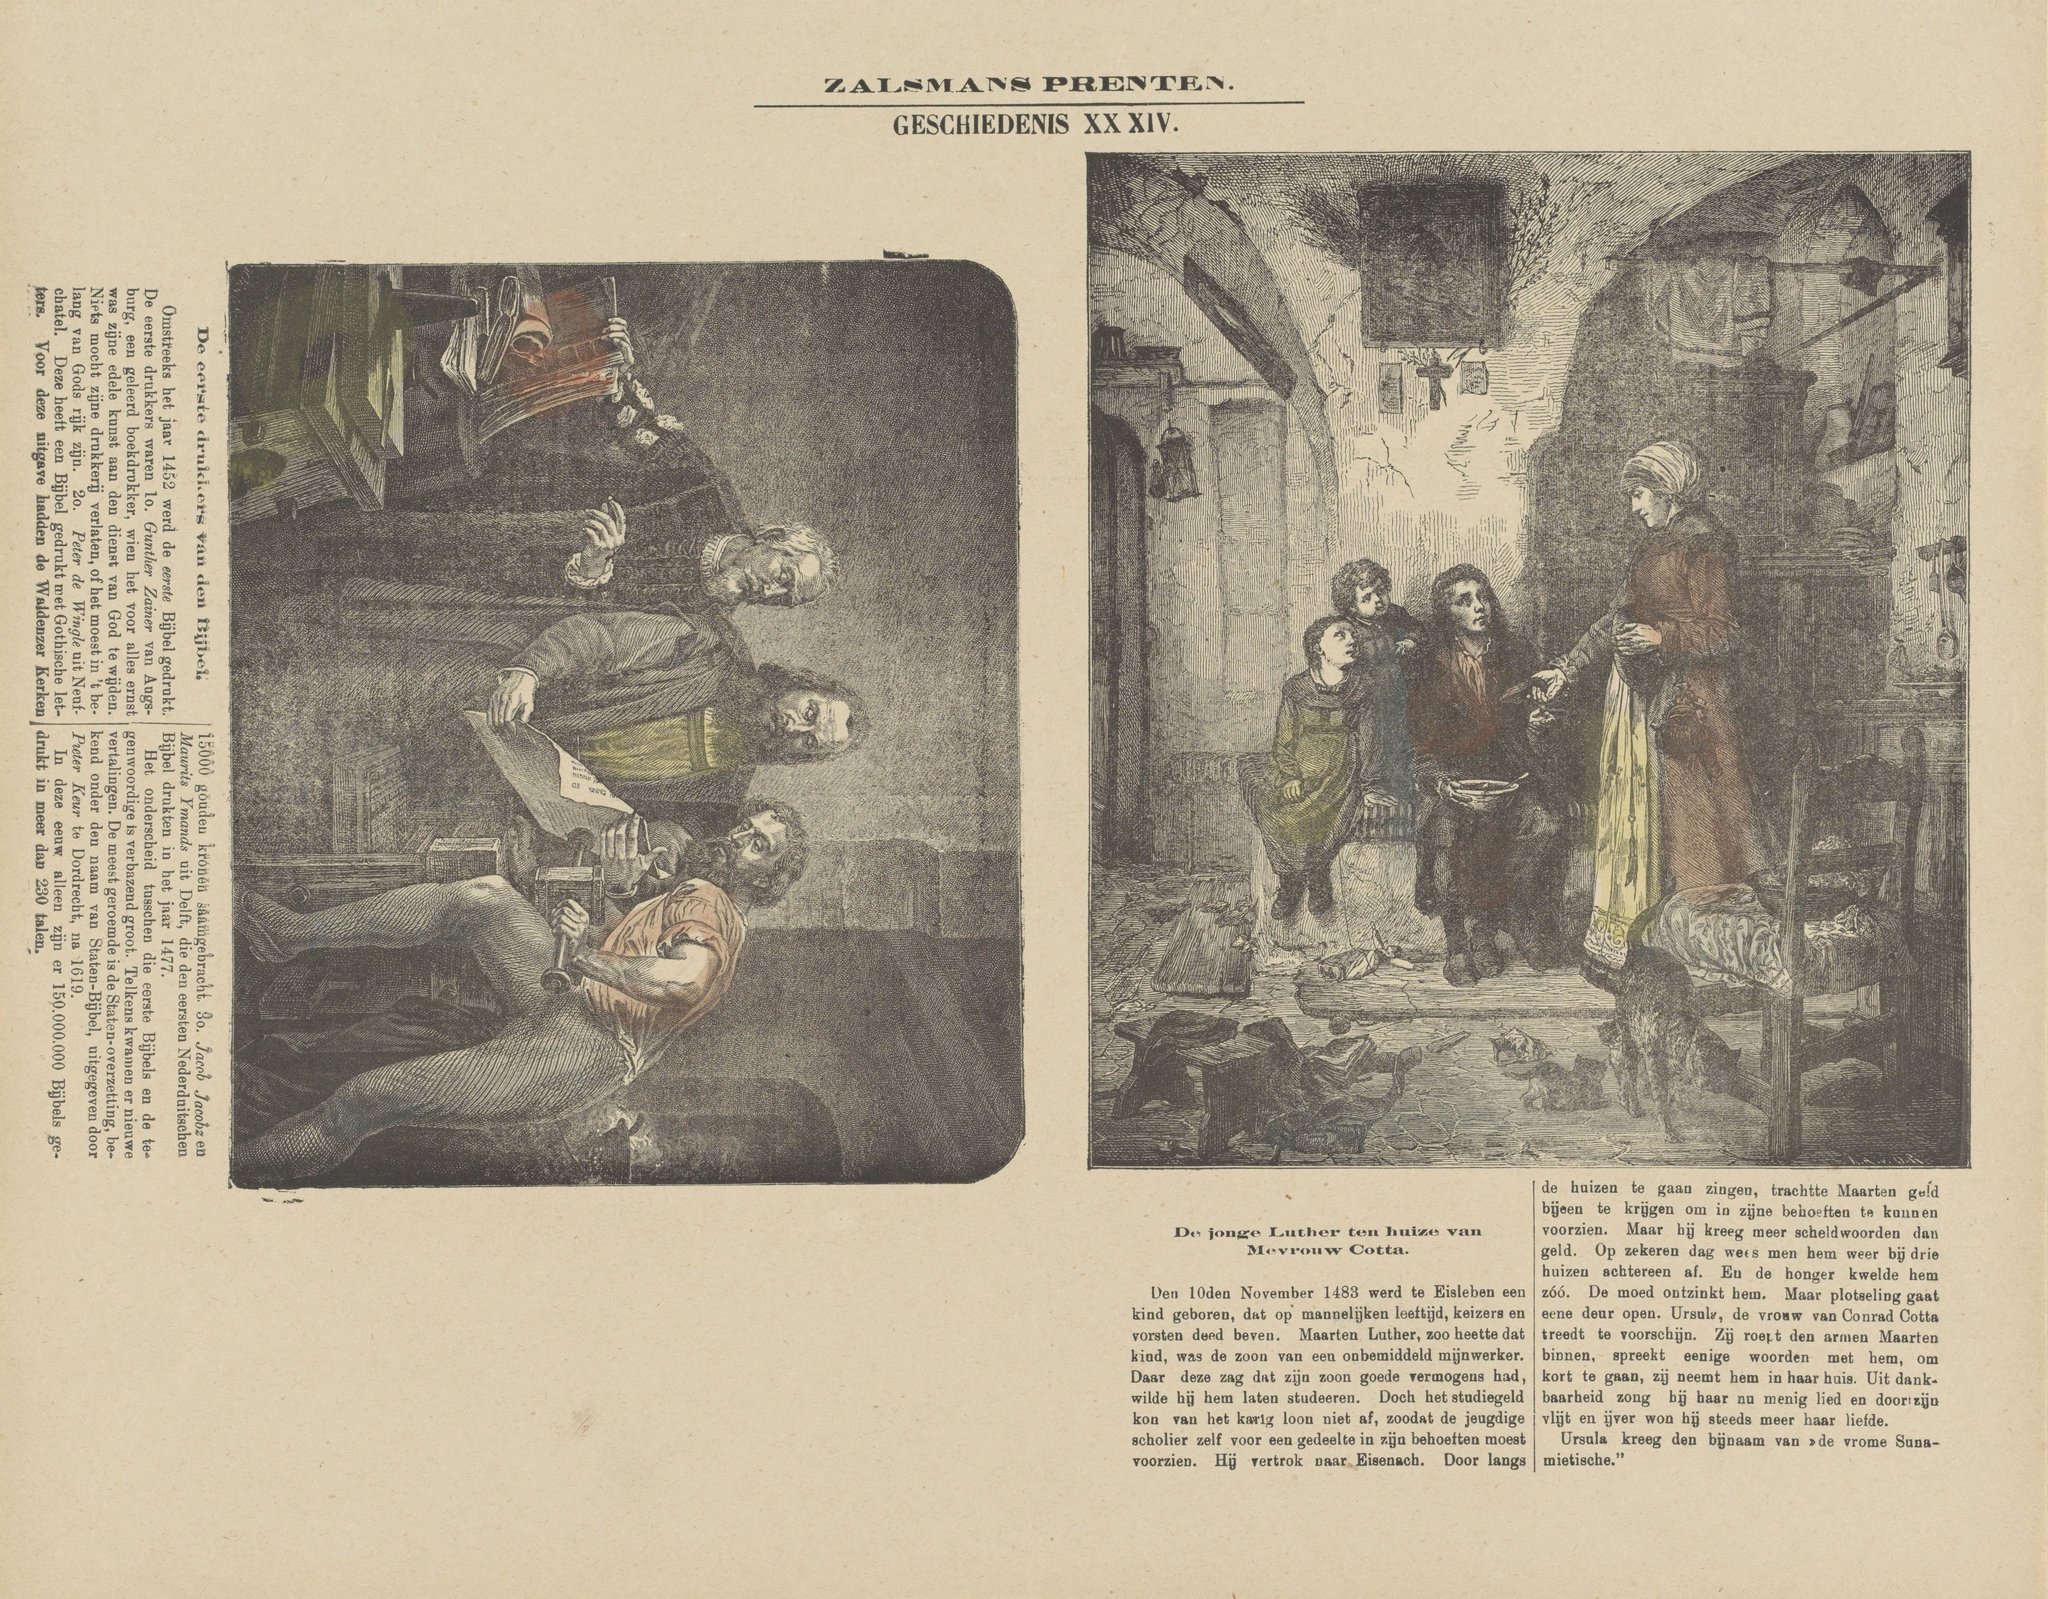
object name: popular print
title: Geschiedenis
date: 1869-1882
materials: paper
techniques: colour, letterpress printing, engraving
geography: netherlands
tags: priest, martin luther, history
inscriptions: collector's mark: Lugt 2760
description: Blad met 2 historische voorstellingen. Links: de eerste drukkers van de Bijbel. Rechts: De jonge Martin Luther bij mevrouw Cotta thuis. Onder of naast elke afbeelding een tekst in boekdruk. Genummerd midden boven: XXXIV.